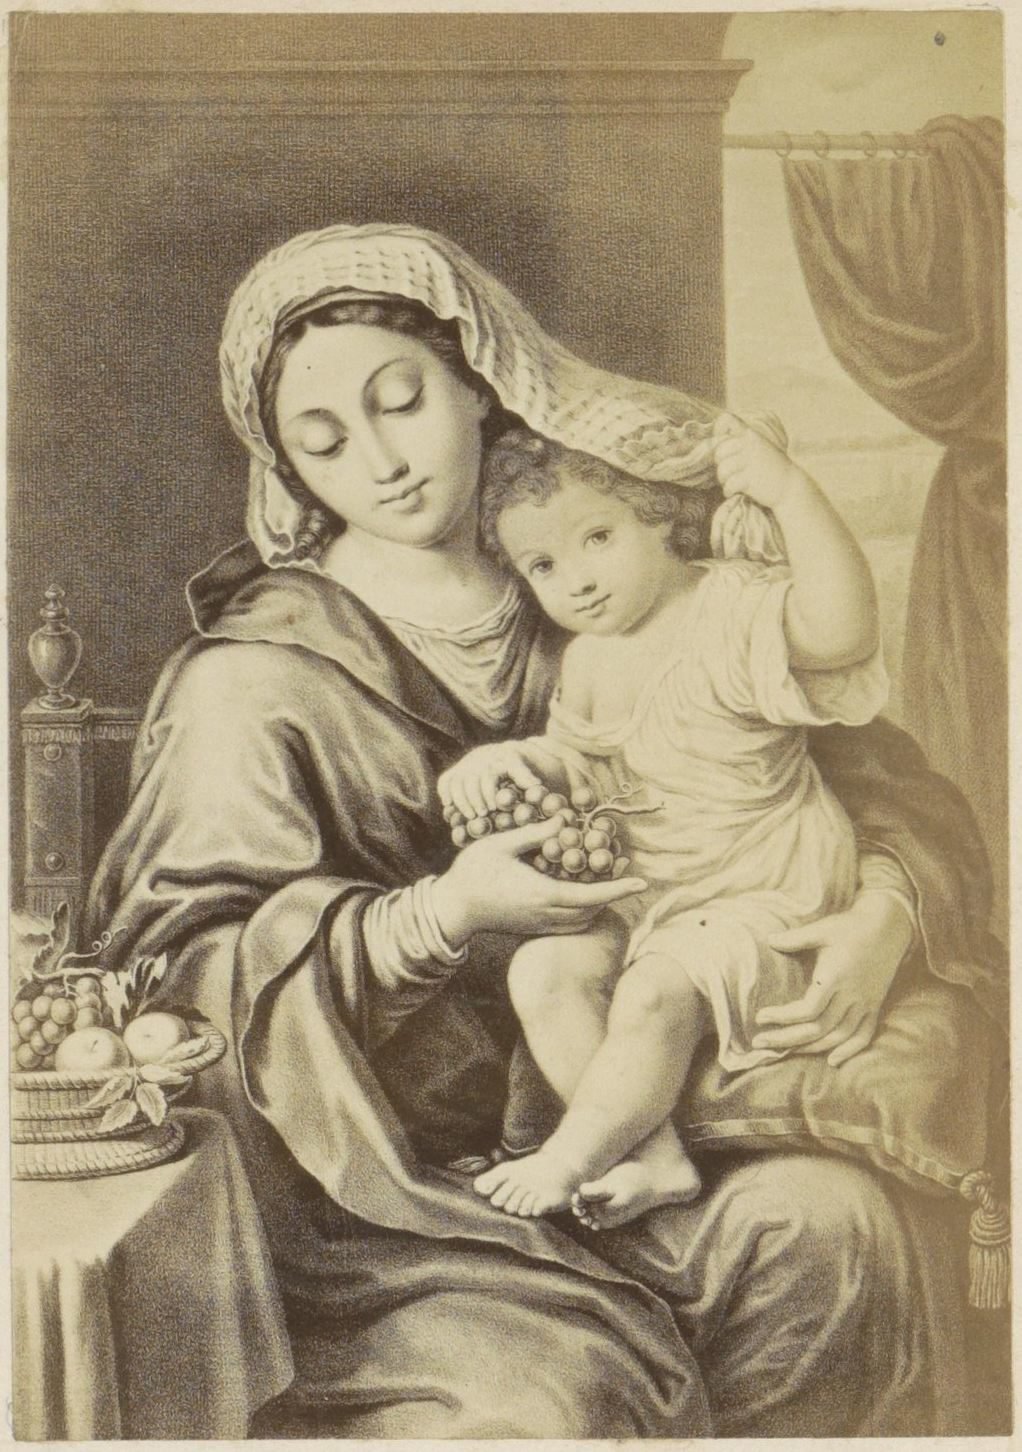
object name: reproduction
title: Fotoreproductie van (vermoedelijk) een prent voorstellend een Maria met kind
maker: Anonymous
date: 1850-1870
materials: paper, photographic support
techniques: albumen print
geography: england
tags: madonna: i.e. mary with the christ-child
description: Onderdeel van Album met foto's van bezienswaardigheden en landschappen in Engeland en van kunst.